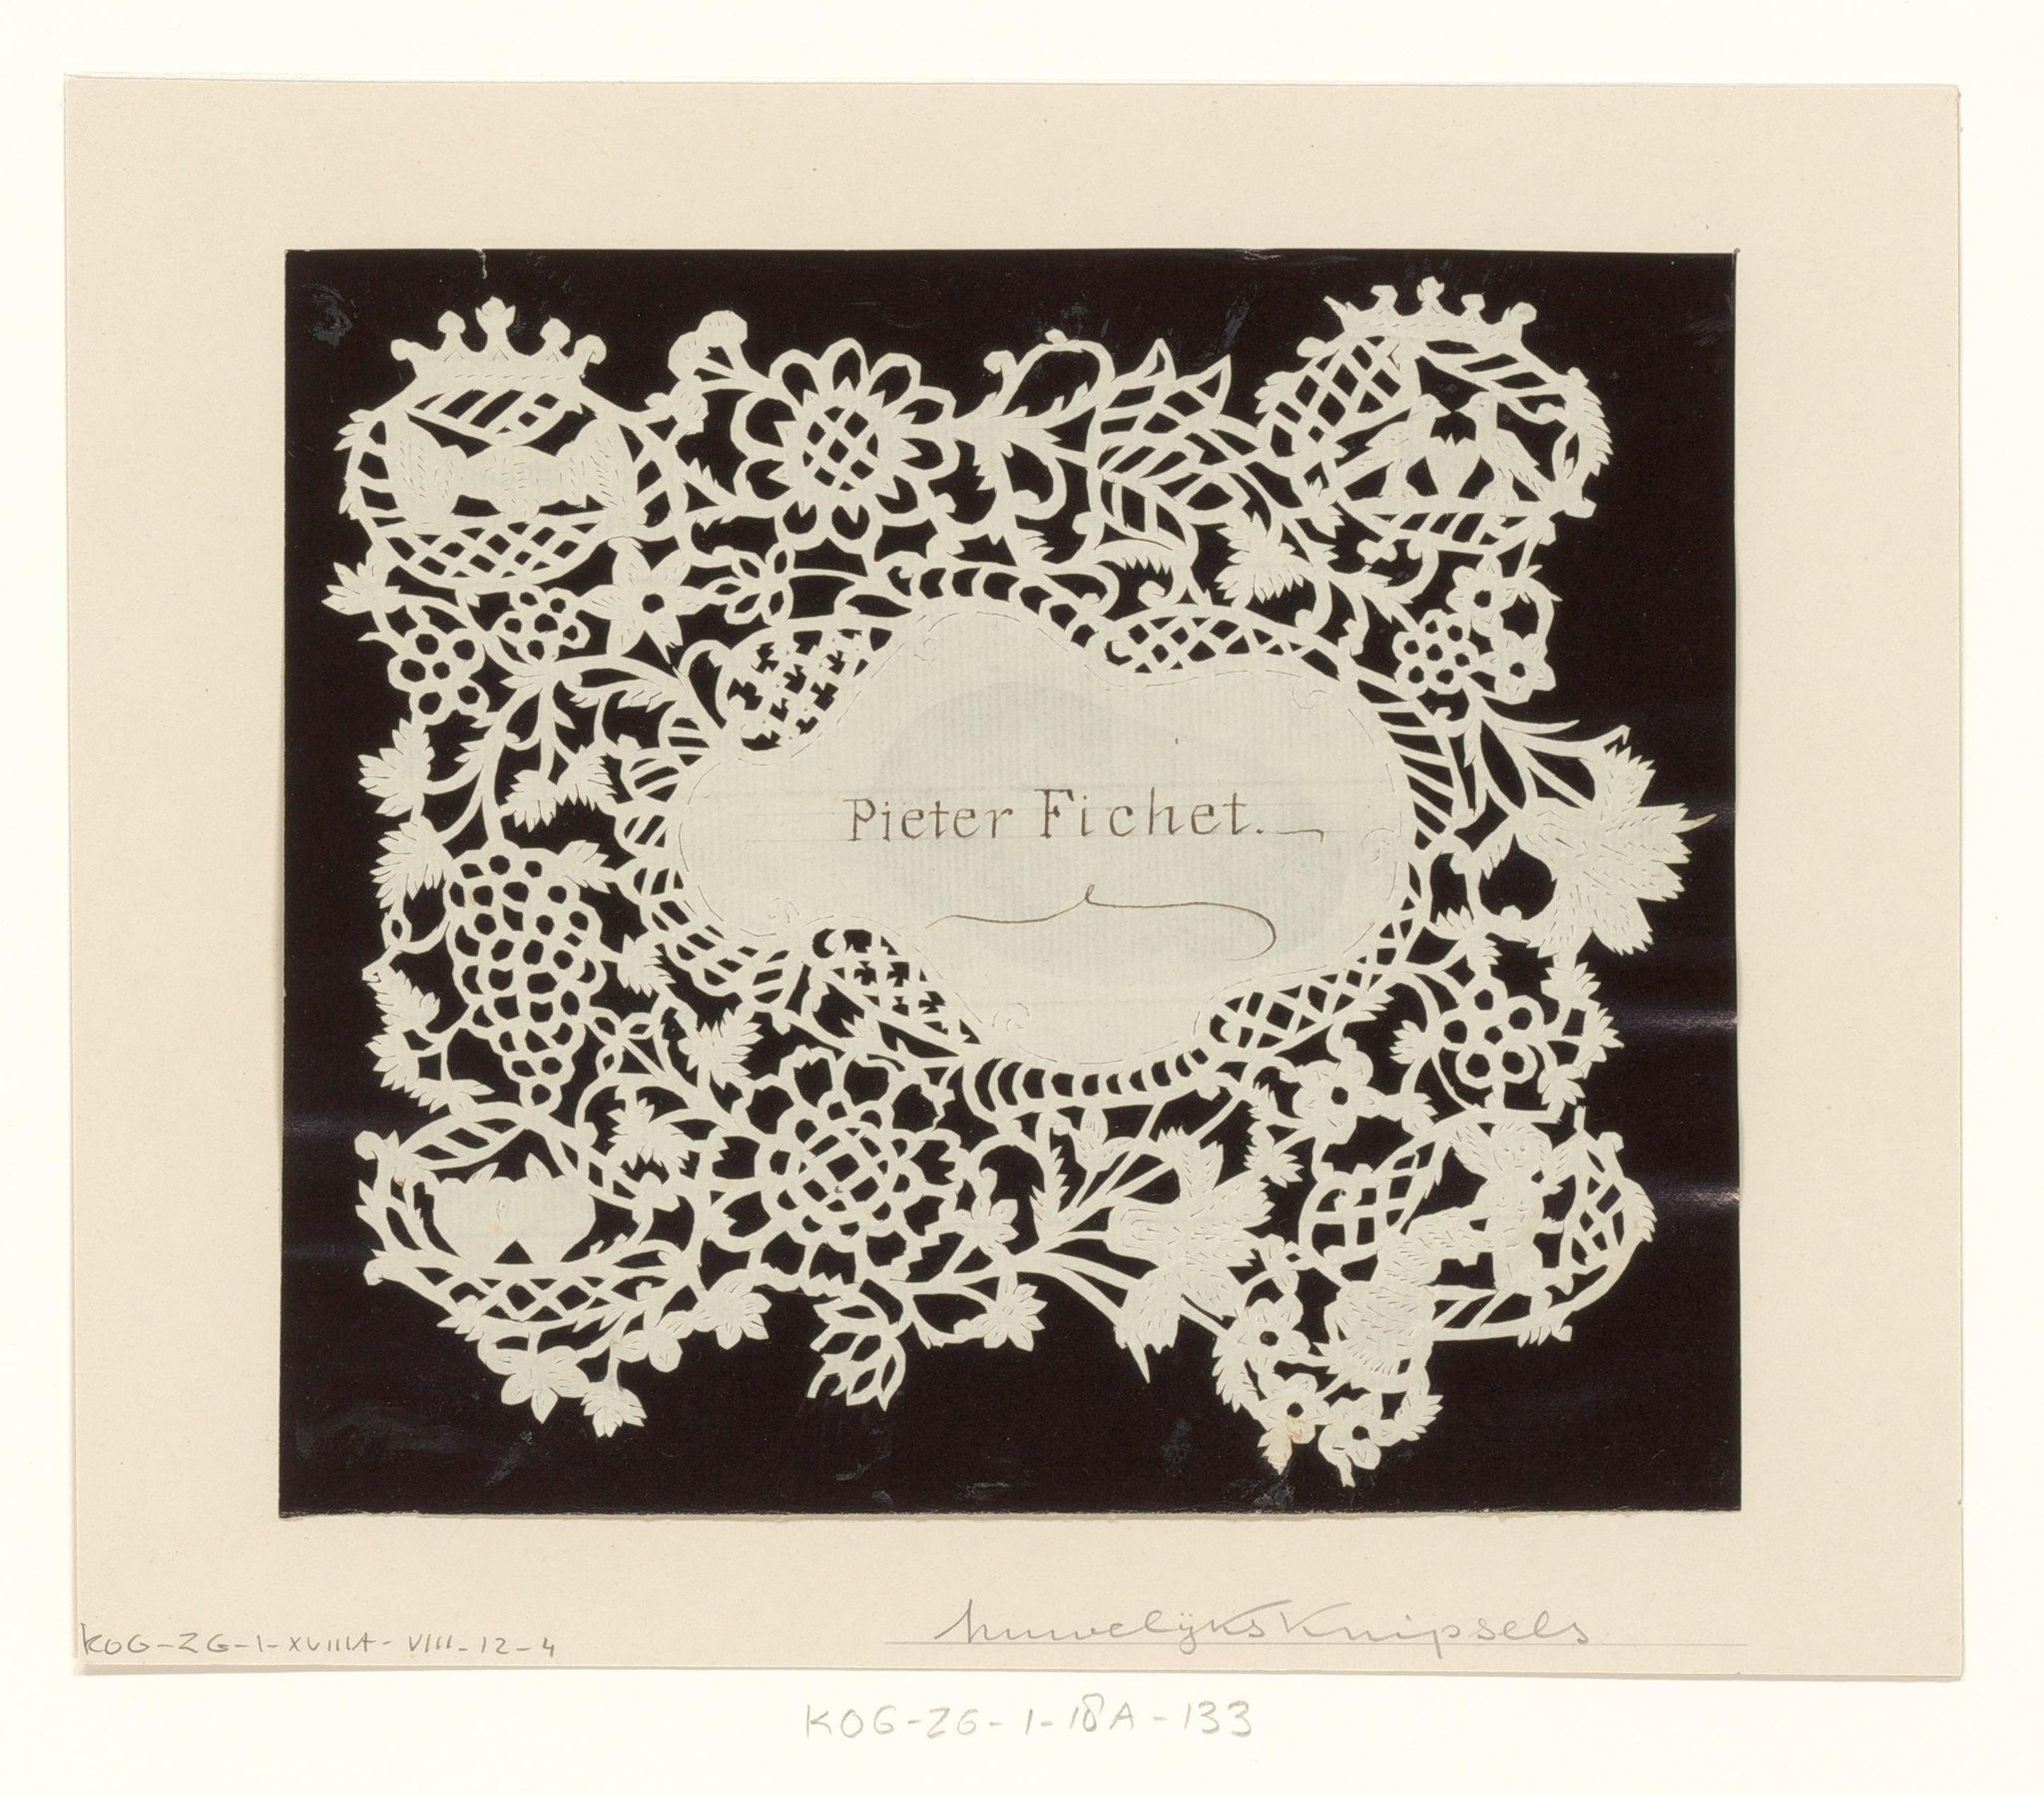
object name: cut paper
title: Huwelijksknipsel voor Pieter Fichet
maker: Anonymous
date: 1750-1849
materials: ink, paper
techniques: cutting, pen, snipping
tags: flowers, marriage, married couple, 'matrimonium'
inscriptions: stamp, collector's mark: Lugt 1641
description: Plaatsaanduiding voor huwelijksmaaltijd voor Pieter Fichet. Om zijn naam ranken met bloemen en een druiventros. Linksboven twee in elkaar grijpende handen. Rechtsboven twee duifjes aan weerszijden van een hart. Linksonder twee brandende harten. Rechtsonder een Amor met een hoorn des overvloeds. Onderwerpsrubrieken binnen de Atlas Zeden en Gewoonten: Schoone kunsten, Knipkunst.